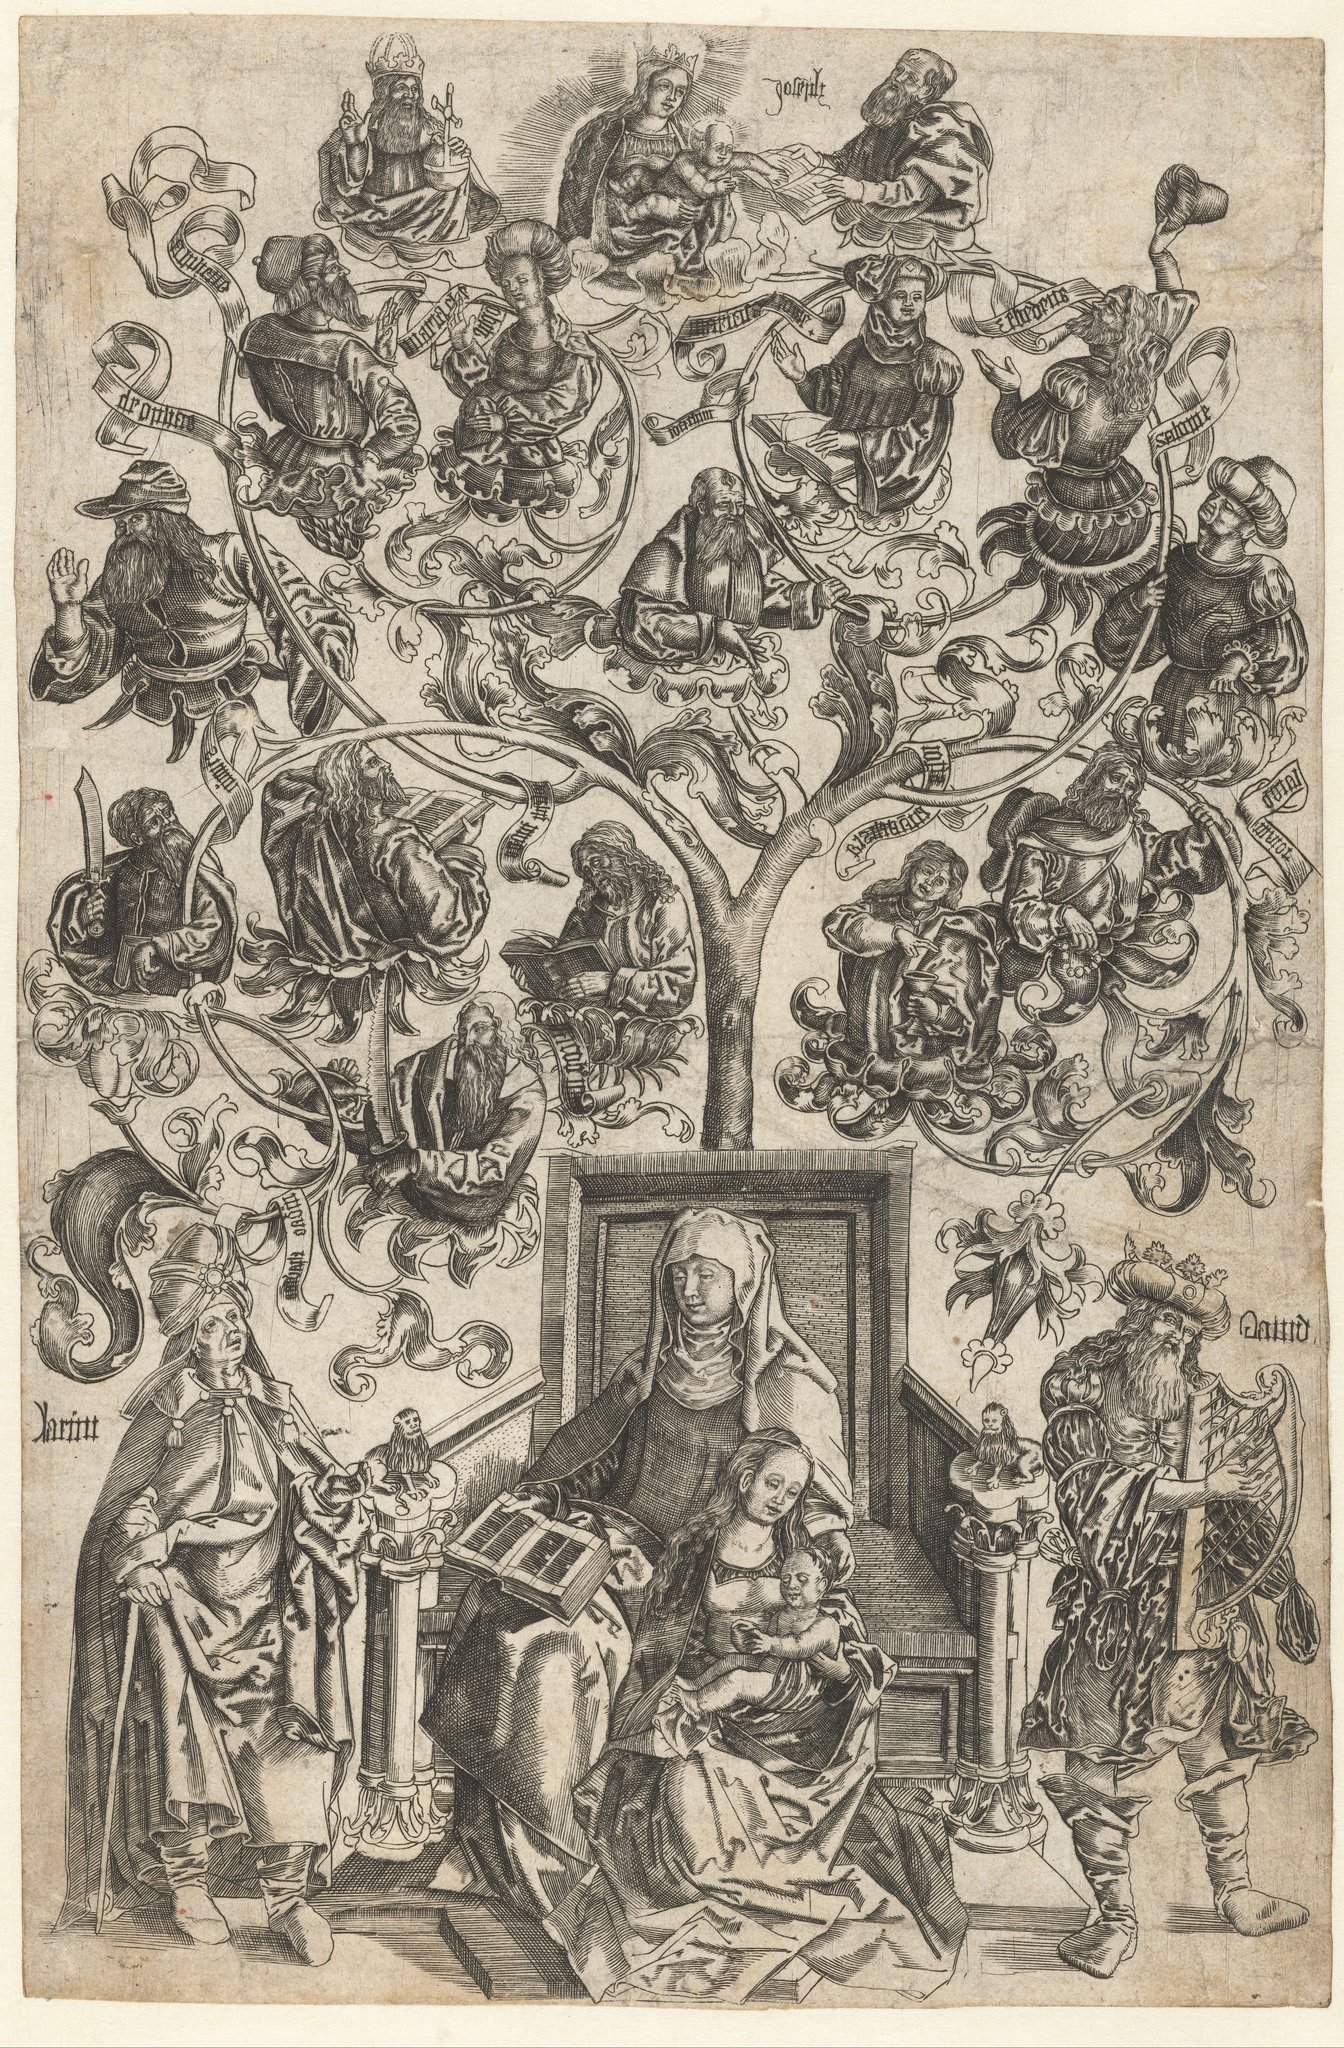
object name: print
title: De stamboom van Maria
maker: Anonymous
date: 1500-1550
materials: paper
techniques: engraving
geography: low countries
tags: 'anna selbdritt', i.e. anna, mary and christ-child close together, tree of jesse: genealogical tree showing christ's ancestors, sprouting from jesse's loins, family lineage, pedigree, genealogical tree or table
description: Anna met Maria en Christuskind op schoot. Achter de troon ontspruit de stamboom. Twee figuren naast troon, waaronder koning David met harp.